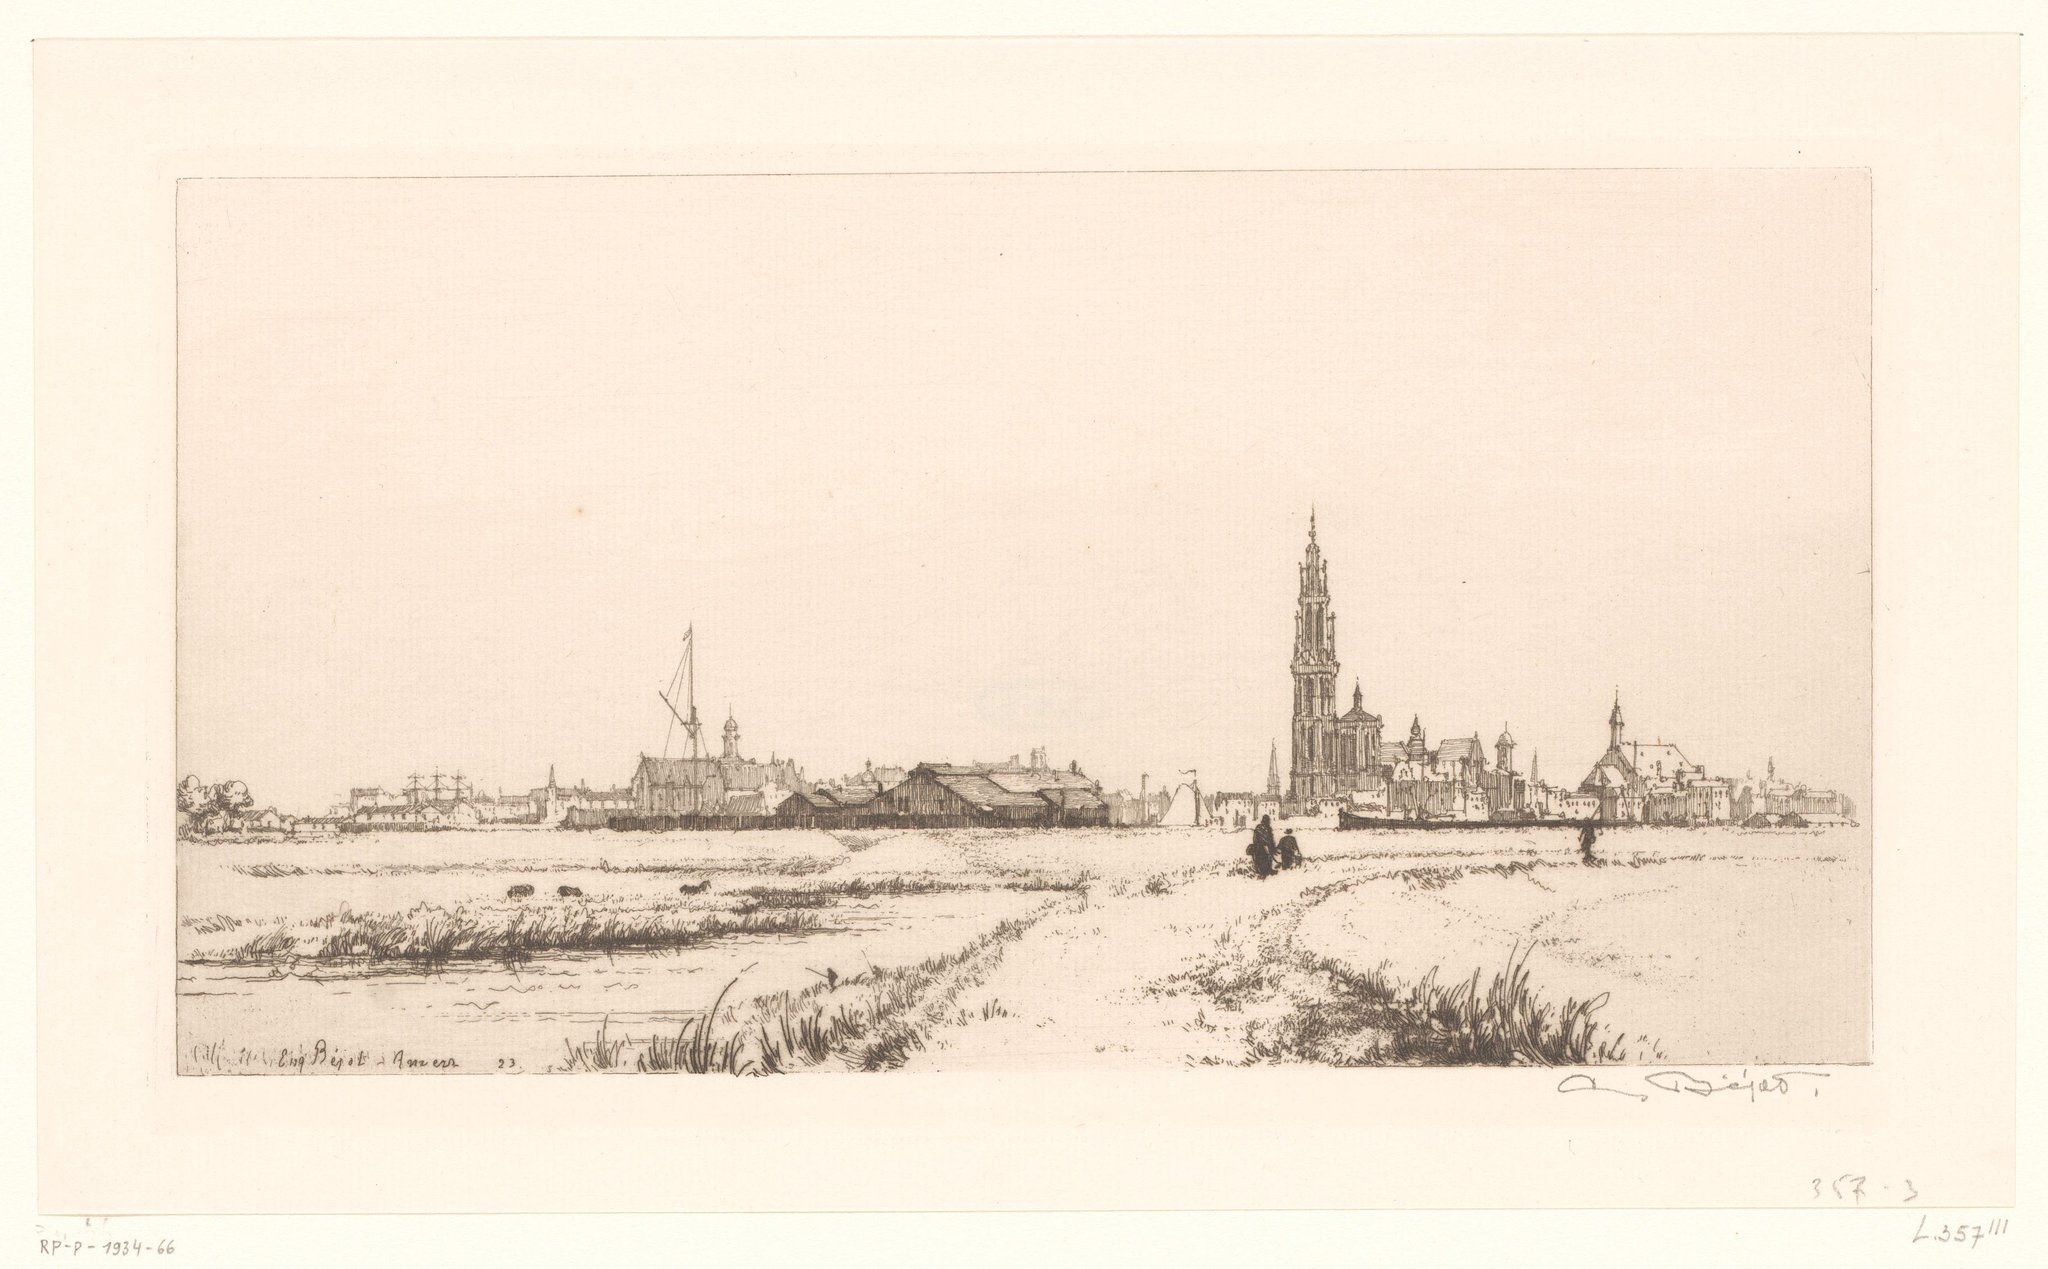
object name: print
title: Zicht op Antwerpen vanaf de dijk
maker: eugène bejot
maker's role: print maker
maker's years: 1867-1931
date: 1923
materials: paper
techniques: drypoint, etching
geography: antwerp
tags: dikes, levee, prospect of city, town panorama, silhouette of city, antwerp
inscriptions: collector's mark: Lugt 2228